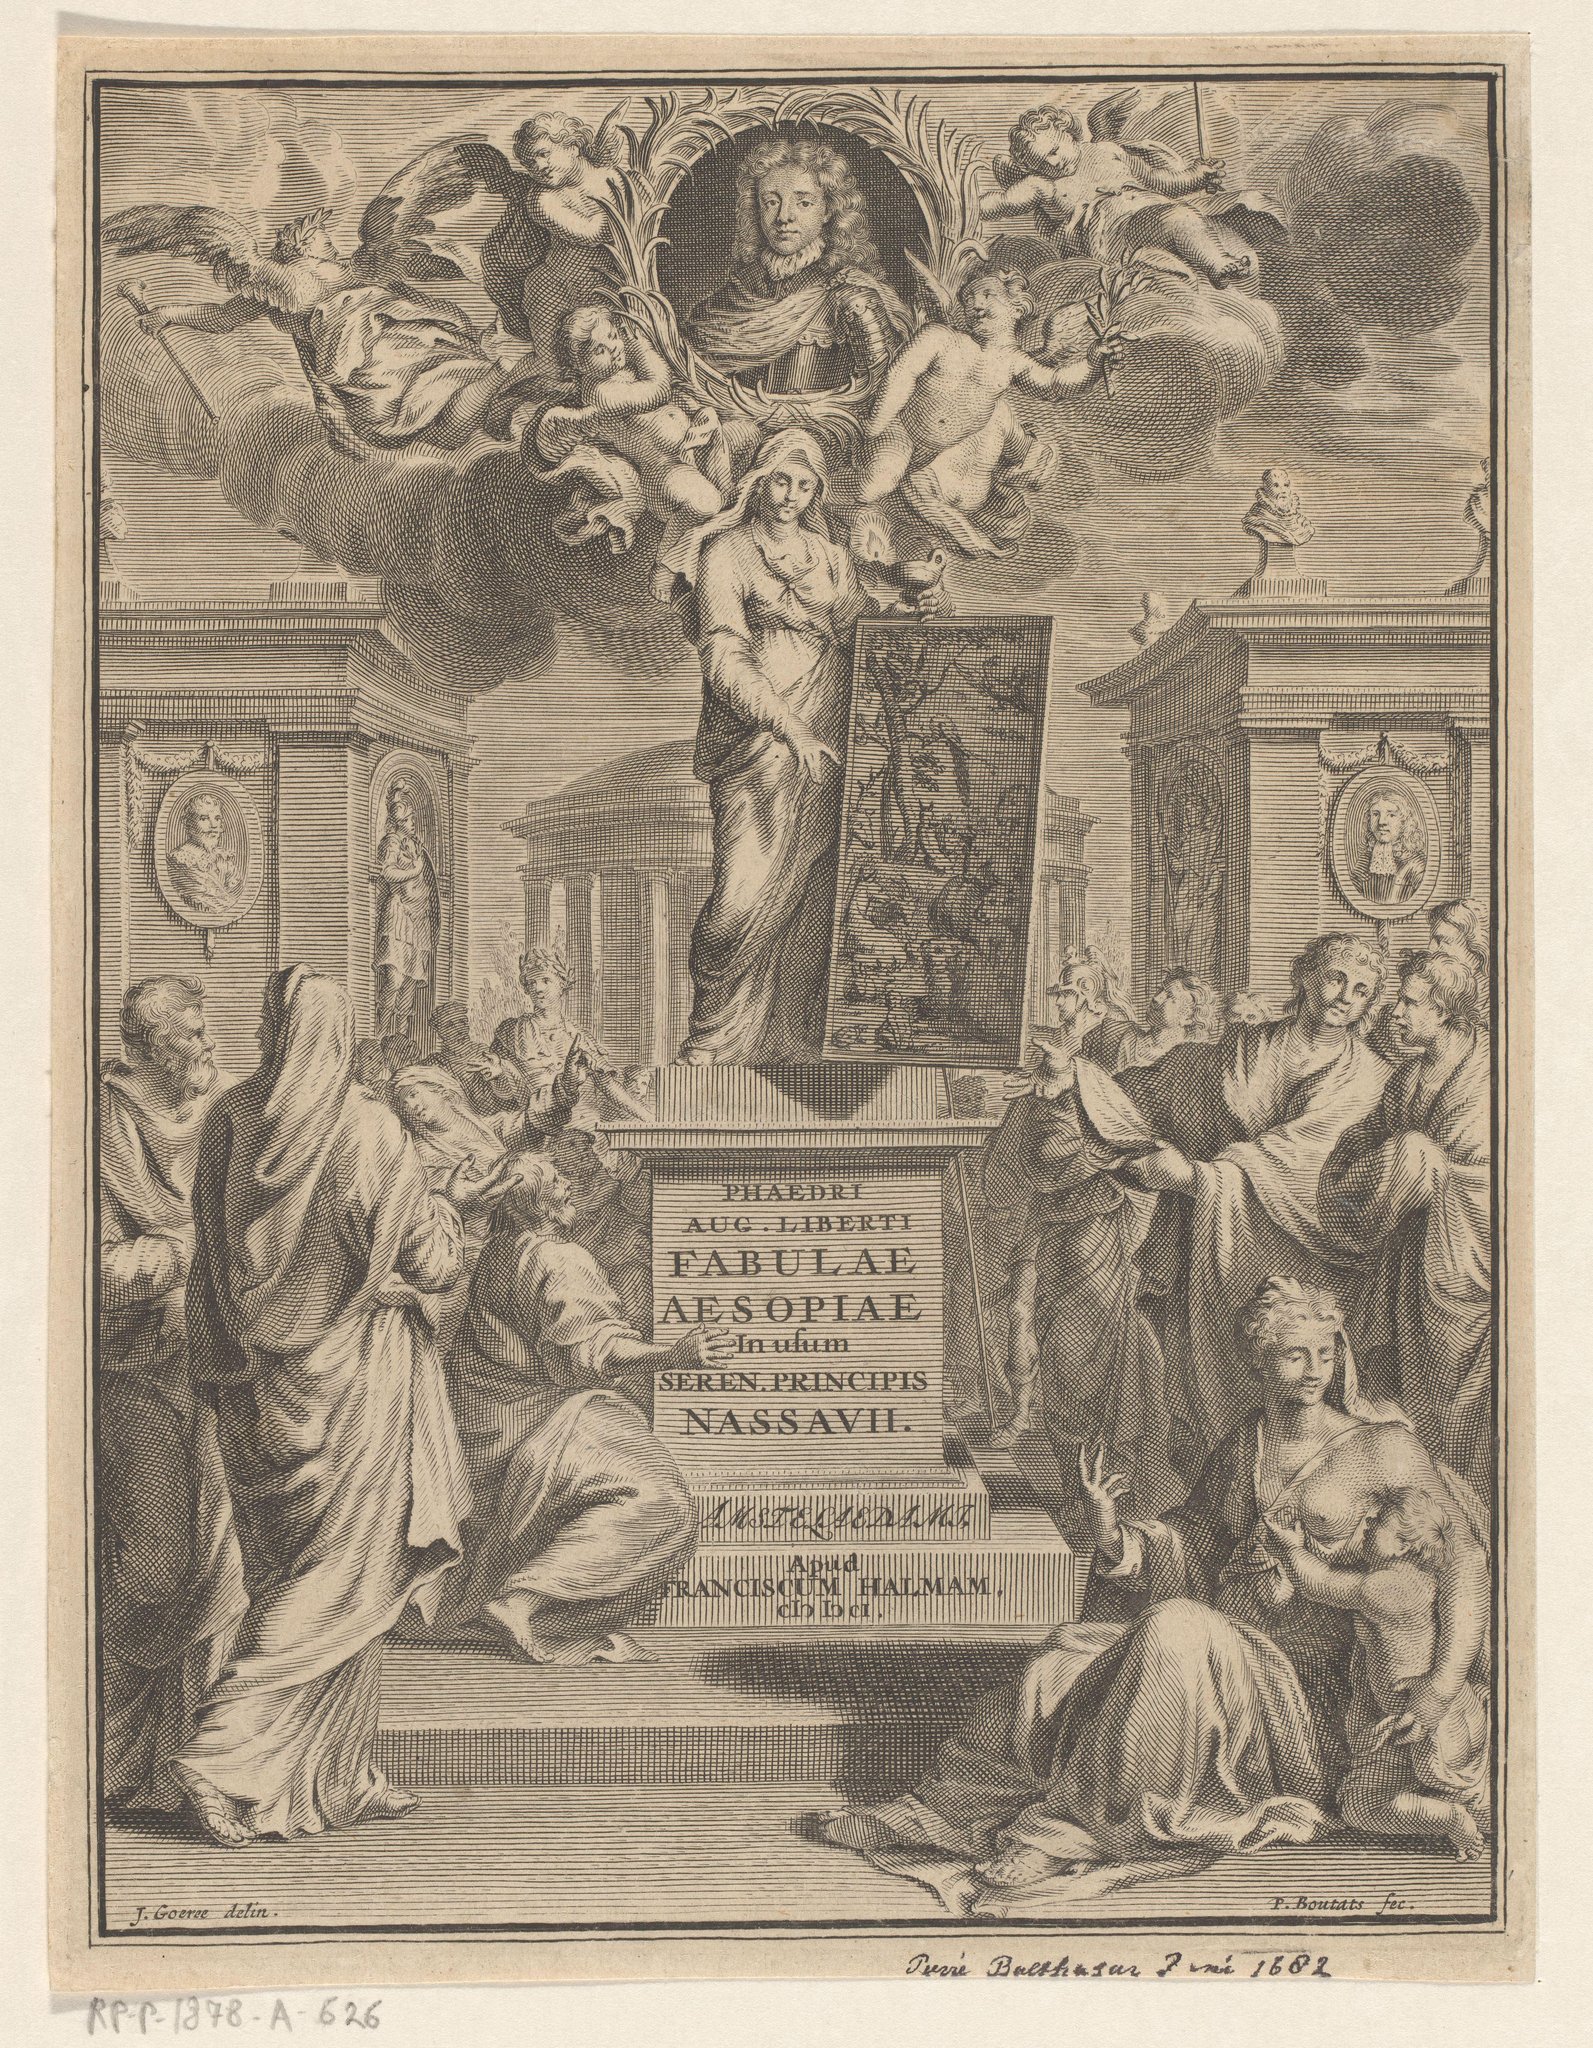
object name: titelblad, titelpagina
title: Fabelen van Aesopus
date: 1701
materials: paper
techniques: engraving, etching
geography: amsterdam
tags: johan willem friso (prins van oranje-nassau), city-view, and landscape with man-made constructions, charity, 'caritas'; 'carità' (ripa) ~ one of the three theological virtues, fables of aesop : use 85(...), art (+ painting), cupids: 'amores', 'amoretti', 'putti', meeting, assembly - aa - in the open air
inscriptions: collector's mark: Lugt 2228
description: Op het midden van een plein vol met mensen een sokkel met daarop de allegorische representatie van Waakzaamheid. Ze heeft een olielamp in haar linkerhand (symbool voor waakzaamheid) en houdt het publiek rondom de sokkel een canvas voor met daarop geschilderd een verzameling van dieren uit de fabels van Aesopus (de paus, de leeuw, de schildpad, de vos, het hert, de haas, etc.). Voor de sokkel zit Caritas. De mensen rondom de sokkel wijzen naar het canvas en discussiëren onder elkaar. Boven de menigte houden verscheidene putti een rond portret omhoog met een afbeelding van Johan Willem Friso. Buste naar links. Op de sokkel de titel van het boek in het Latijn.